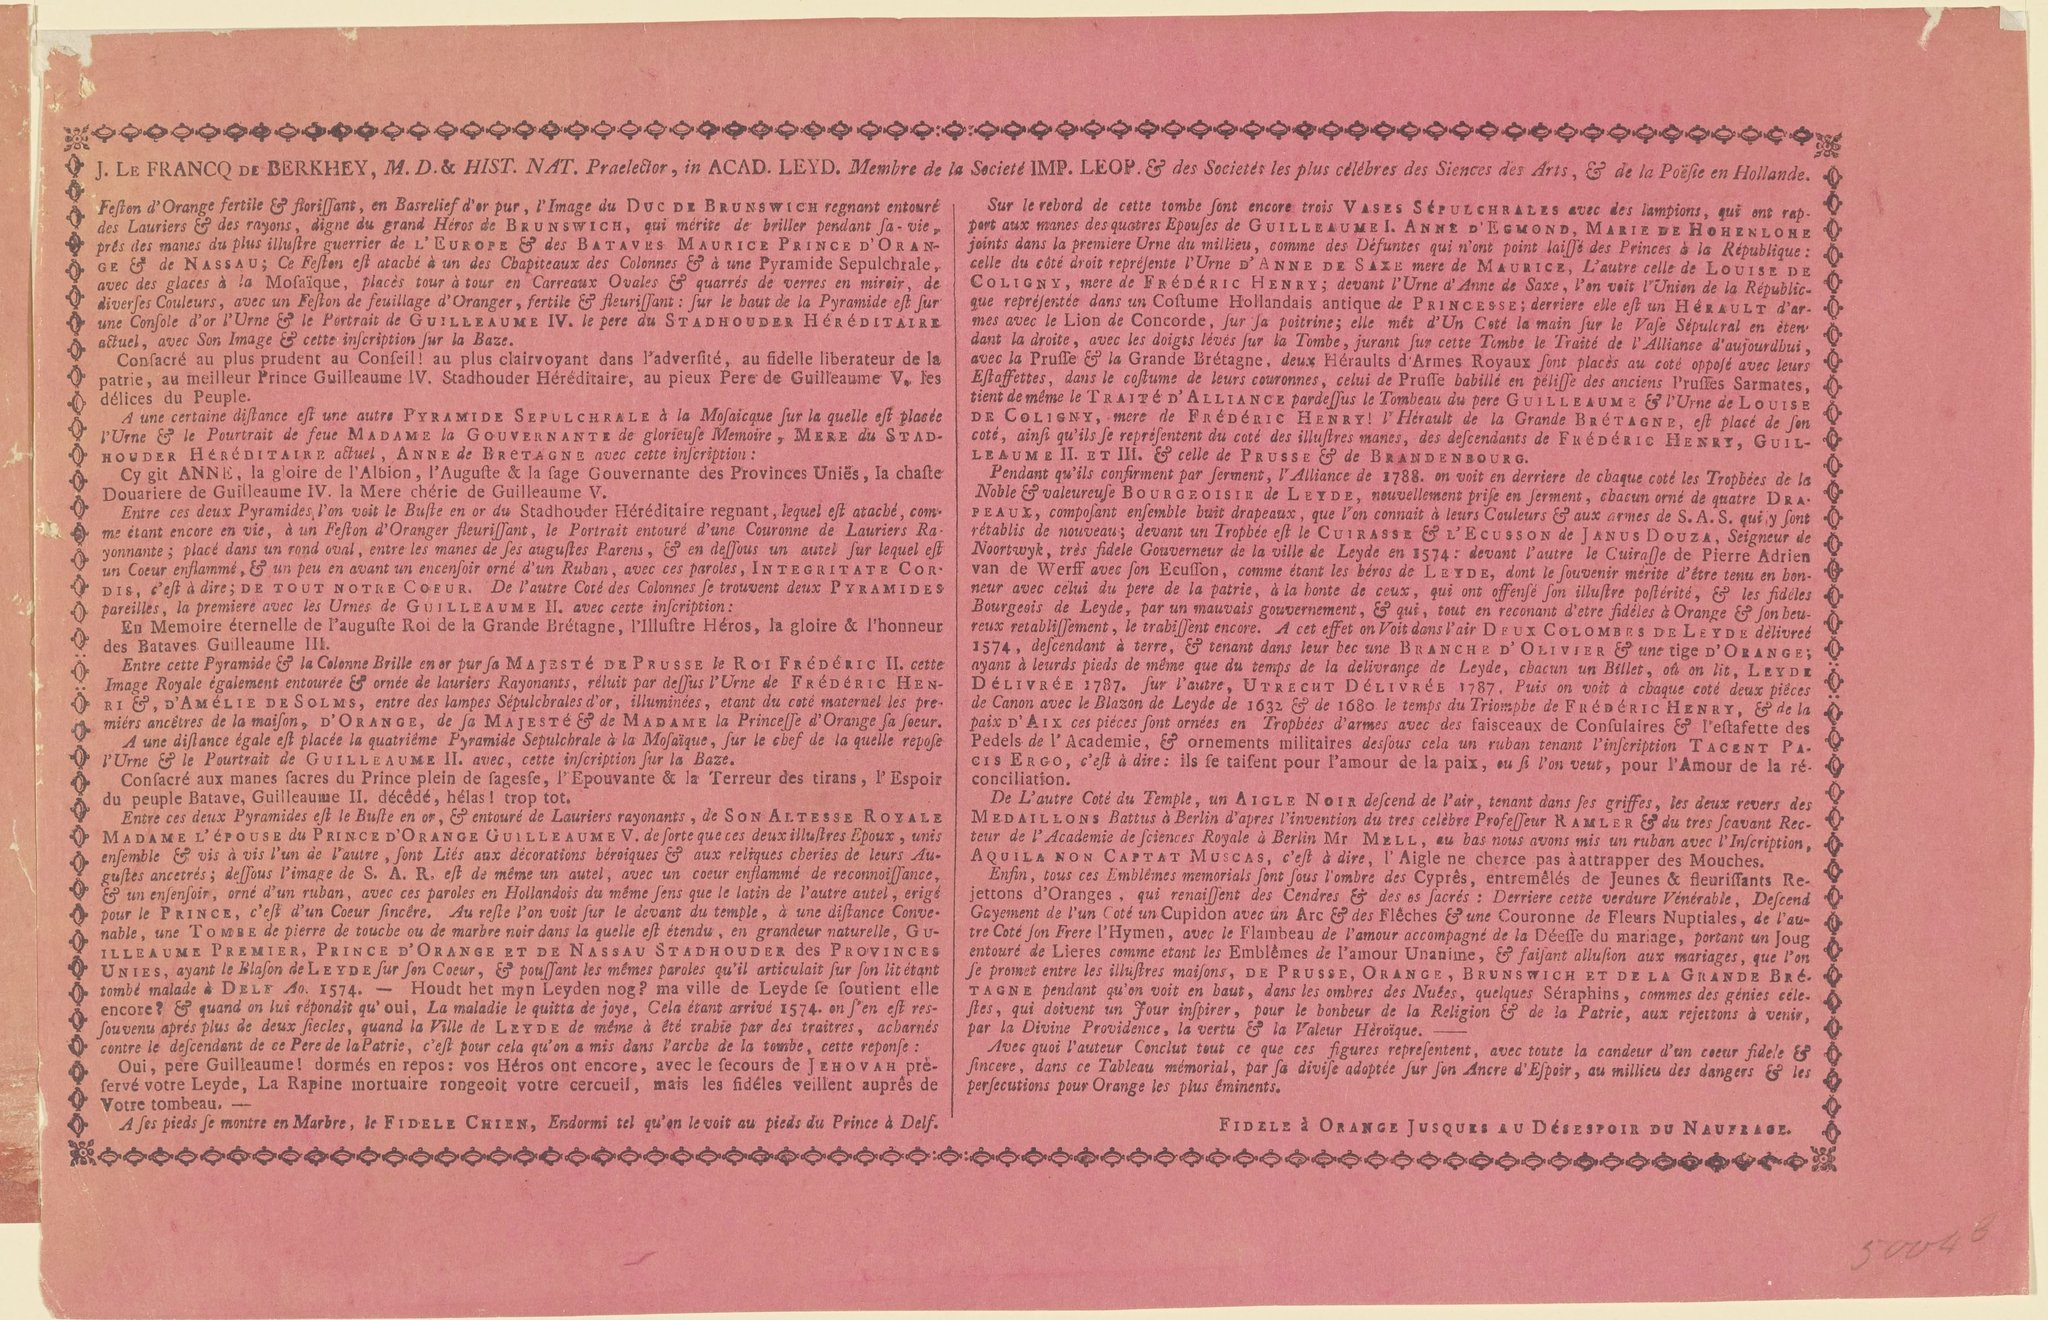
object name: text sheet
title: Explication du Tableau & Illumination, Sur la Restitution du Stadhouderat & de la Constititon des Provinces Unies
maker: johannes le francq van berkhey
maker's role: draughtsman, print maker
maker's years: 1729-1812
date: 1789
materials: paper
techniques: letterpress printing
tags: herstel van stadhouder willem v (1787), pruisische inval in de republiek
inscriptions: collector's mark: Lugt 2228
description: Tweede deel van een tekstblad met een verklaringing van de allegorie ter ere van de koning van Pruisen voor zijn herstel van het stadhouderschap van Willem V, 1788. Tekst in twee kolommen in het Frans.